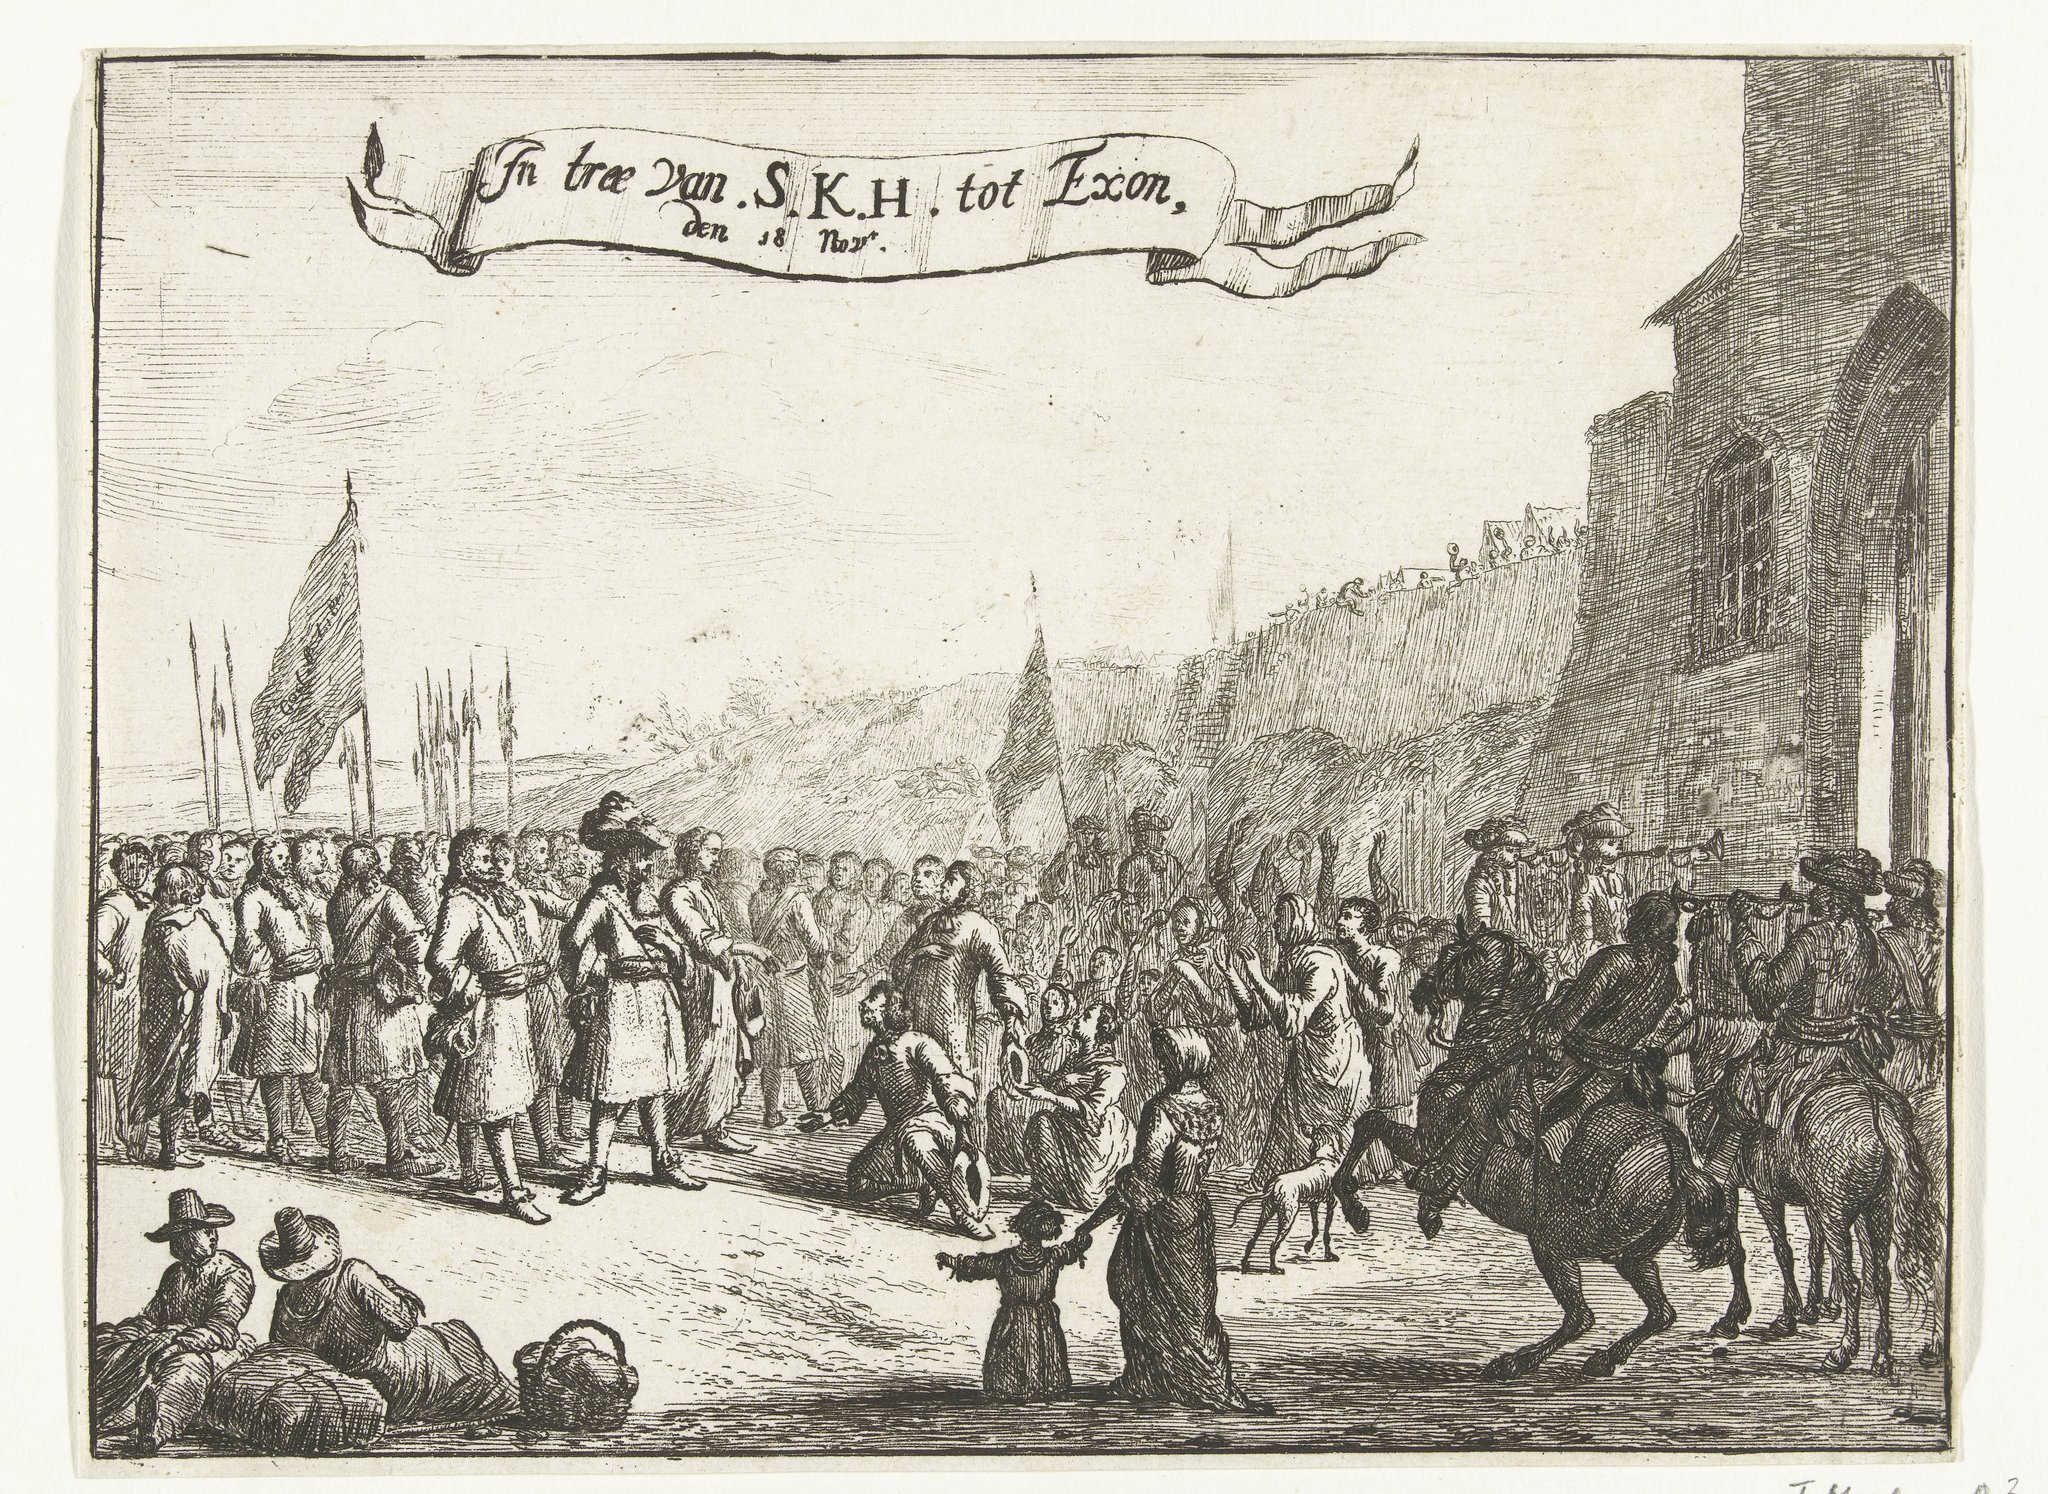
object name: print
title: Aankomst van de prins bij Exmouth, 1688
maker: Anonymous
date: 1688-1689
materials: paper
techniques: etching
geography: northern netherlands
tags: the hague, william iii (prince of orange and king of england, scotland, and ireland), being welcomed ~ travelling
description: Prins Willem III met zijn leger wordt bij de stadspoort van Exmouth (of Exeter) verwelkomd door vertegenwoordigers van de stad, 18 november 1688.